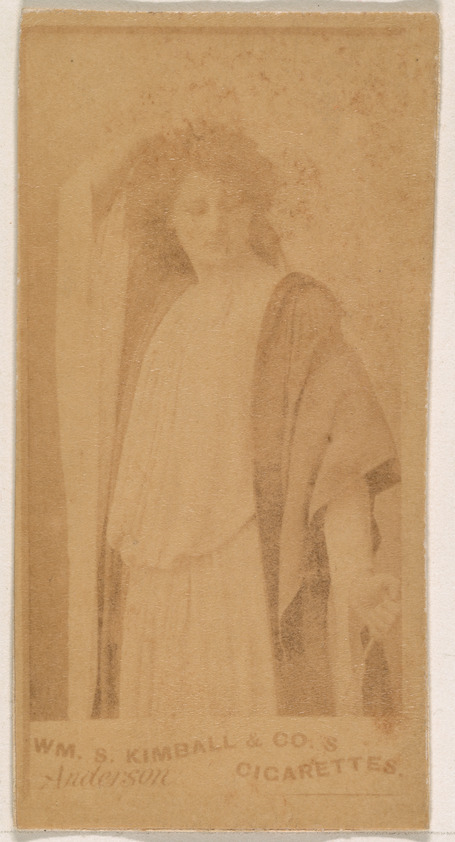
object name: photograph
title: Miss Anderson, from the Actresses series (N203) issued by Wm. S. Kimball & Co.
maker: william s. kimball & company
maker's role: publisher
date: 1889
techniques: color lithograph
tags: portraits,women,actresses